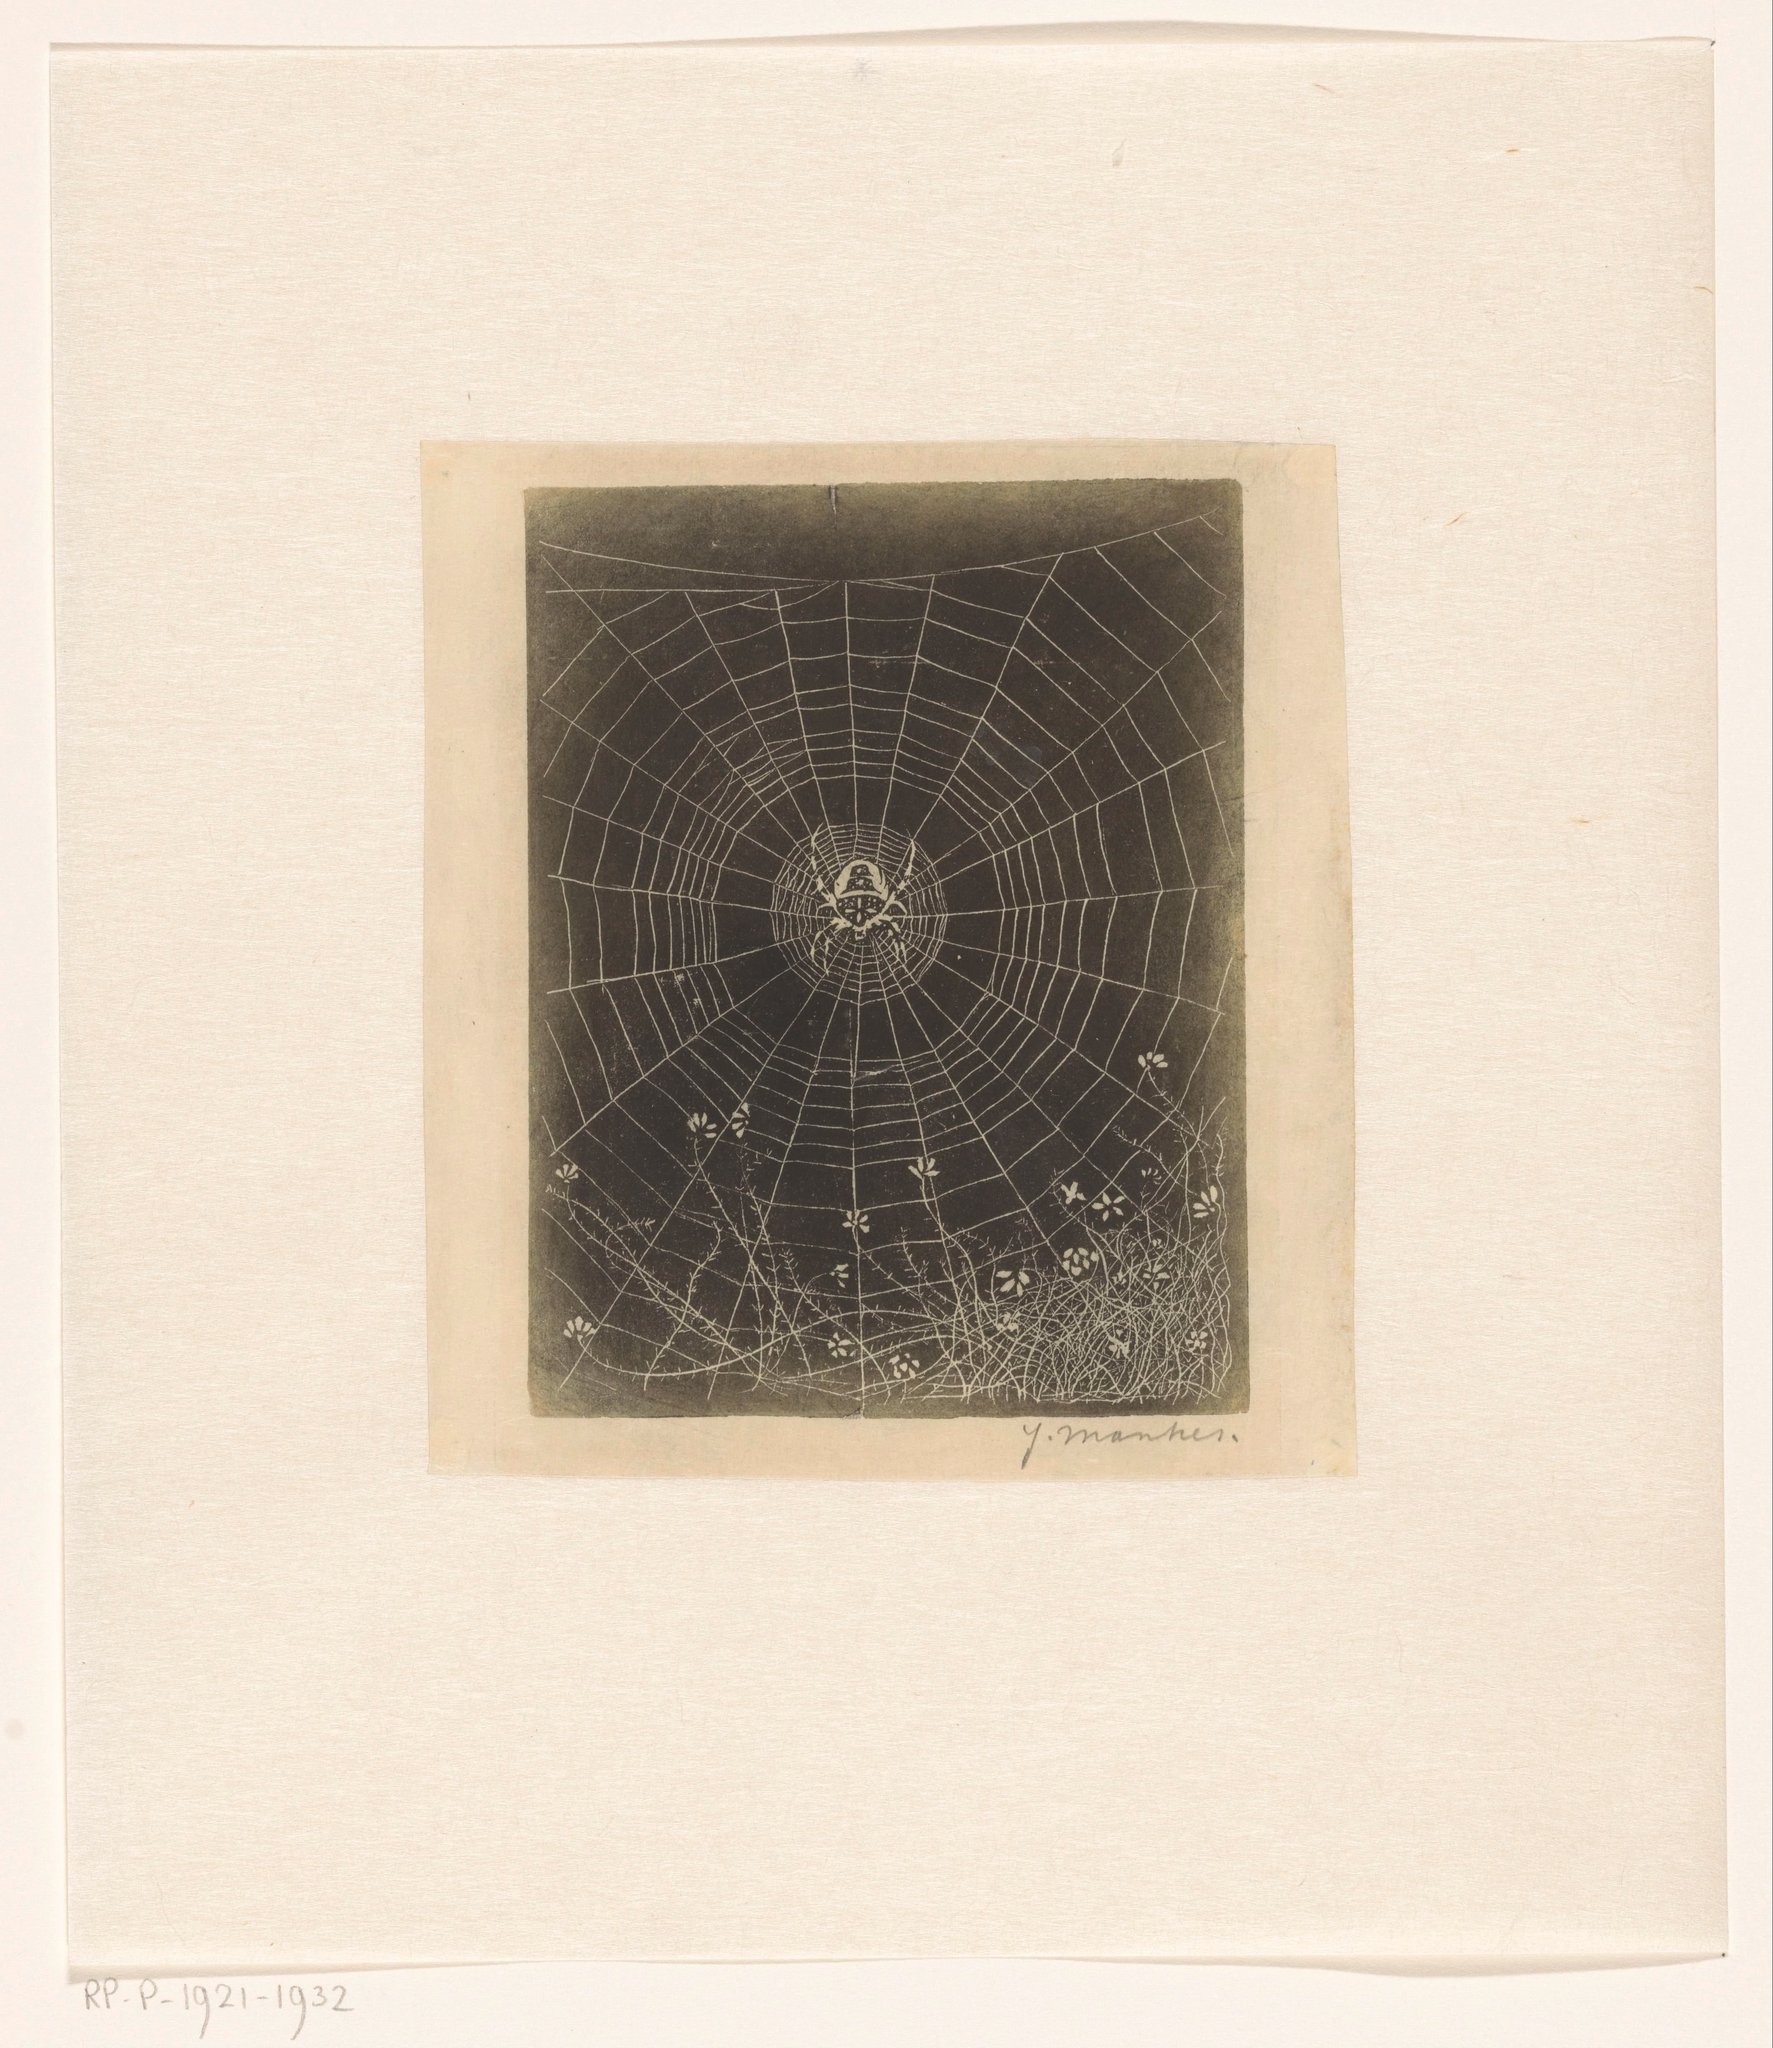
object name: print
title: Kruisspin in zijn web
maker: jan mankes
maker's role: draughtsman, painter, print maker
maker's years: 1889-1920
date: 1909-1916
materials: paper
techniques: engraving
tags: spiders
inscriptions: collector's mark: Lugt 2228